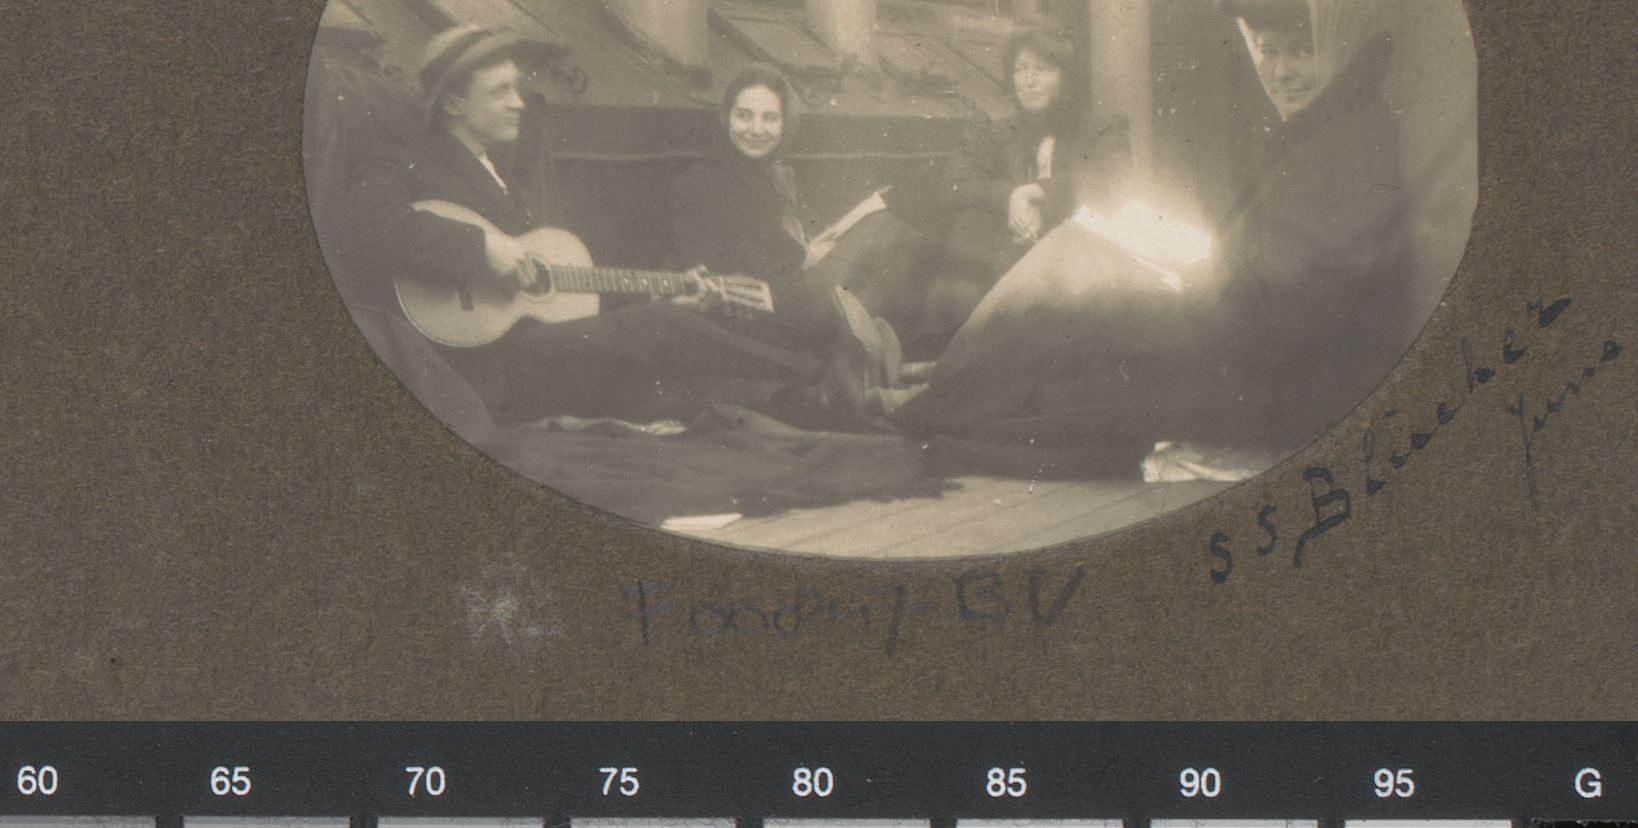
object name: album leaf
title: Musicerend gezelschap aan boord van SS Blücher, vermoedelijk tussen Hamburg en New York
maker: Anonymous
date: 1906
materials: cardboard, paper, photographic support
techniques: gelatin silver print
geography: atlantic ocean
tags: passenger liner, making music; musician with instrument - cc - out of doors, atlantic ocean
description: Onderdeel van Reisalbum van een Nederlandse familie met bezienswaardigheden in Europa, Egypte en New York.